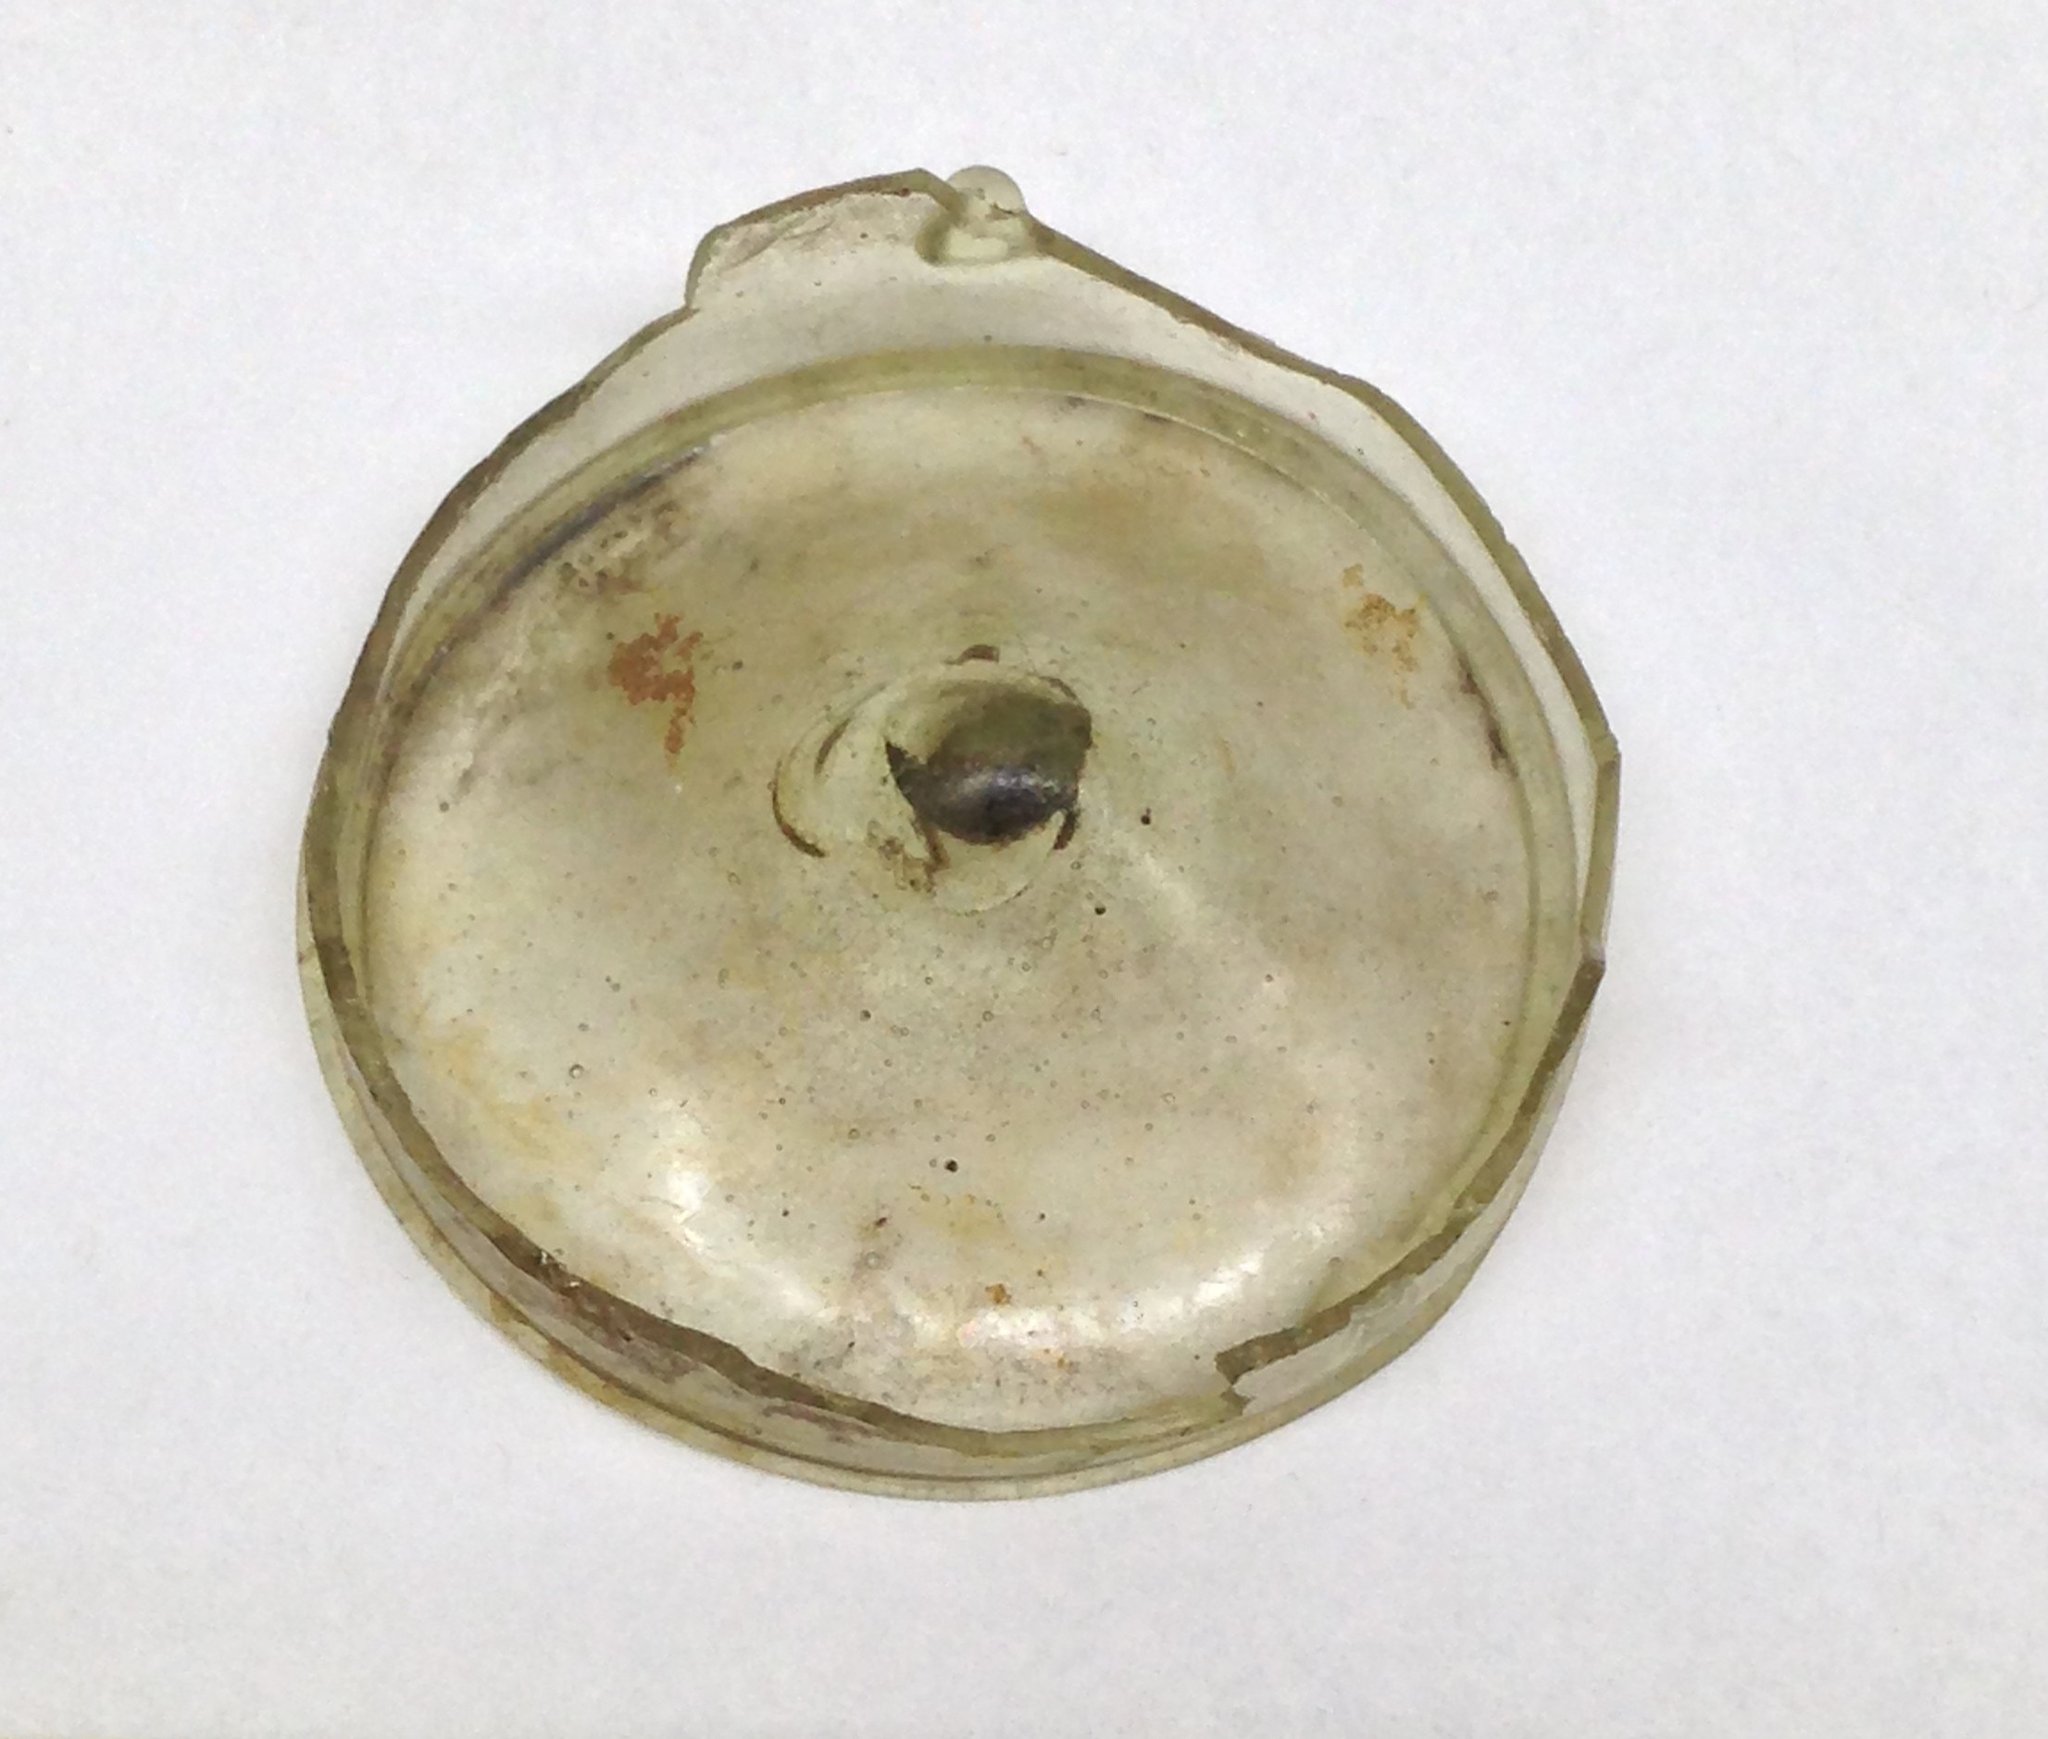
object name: glass fragment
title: Fragment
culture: european or middle eastern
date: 1150-1250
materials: ceramic, glass